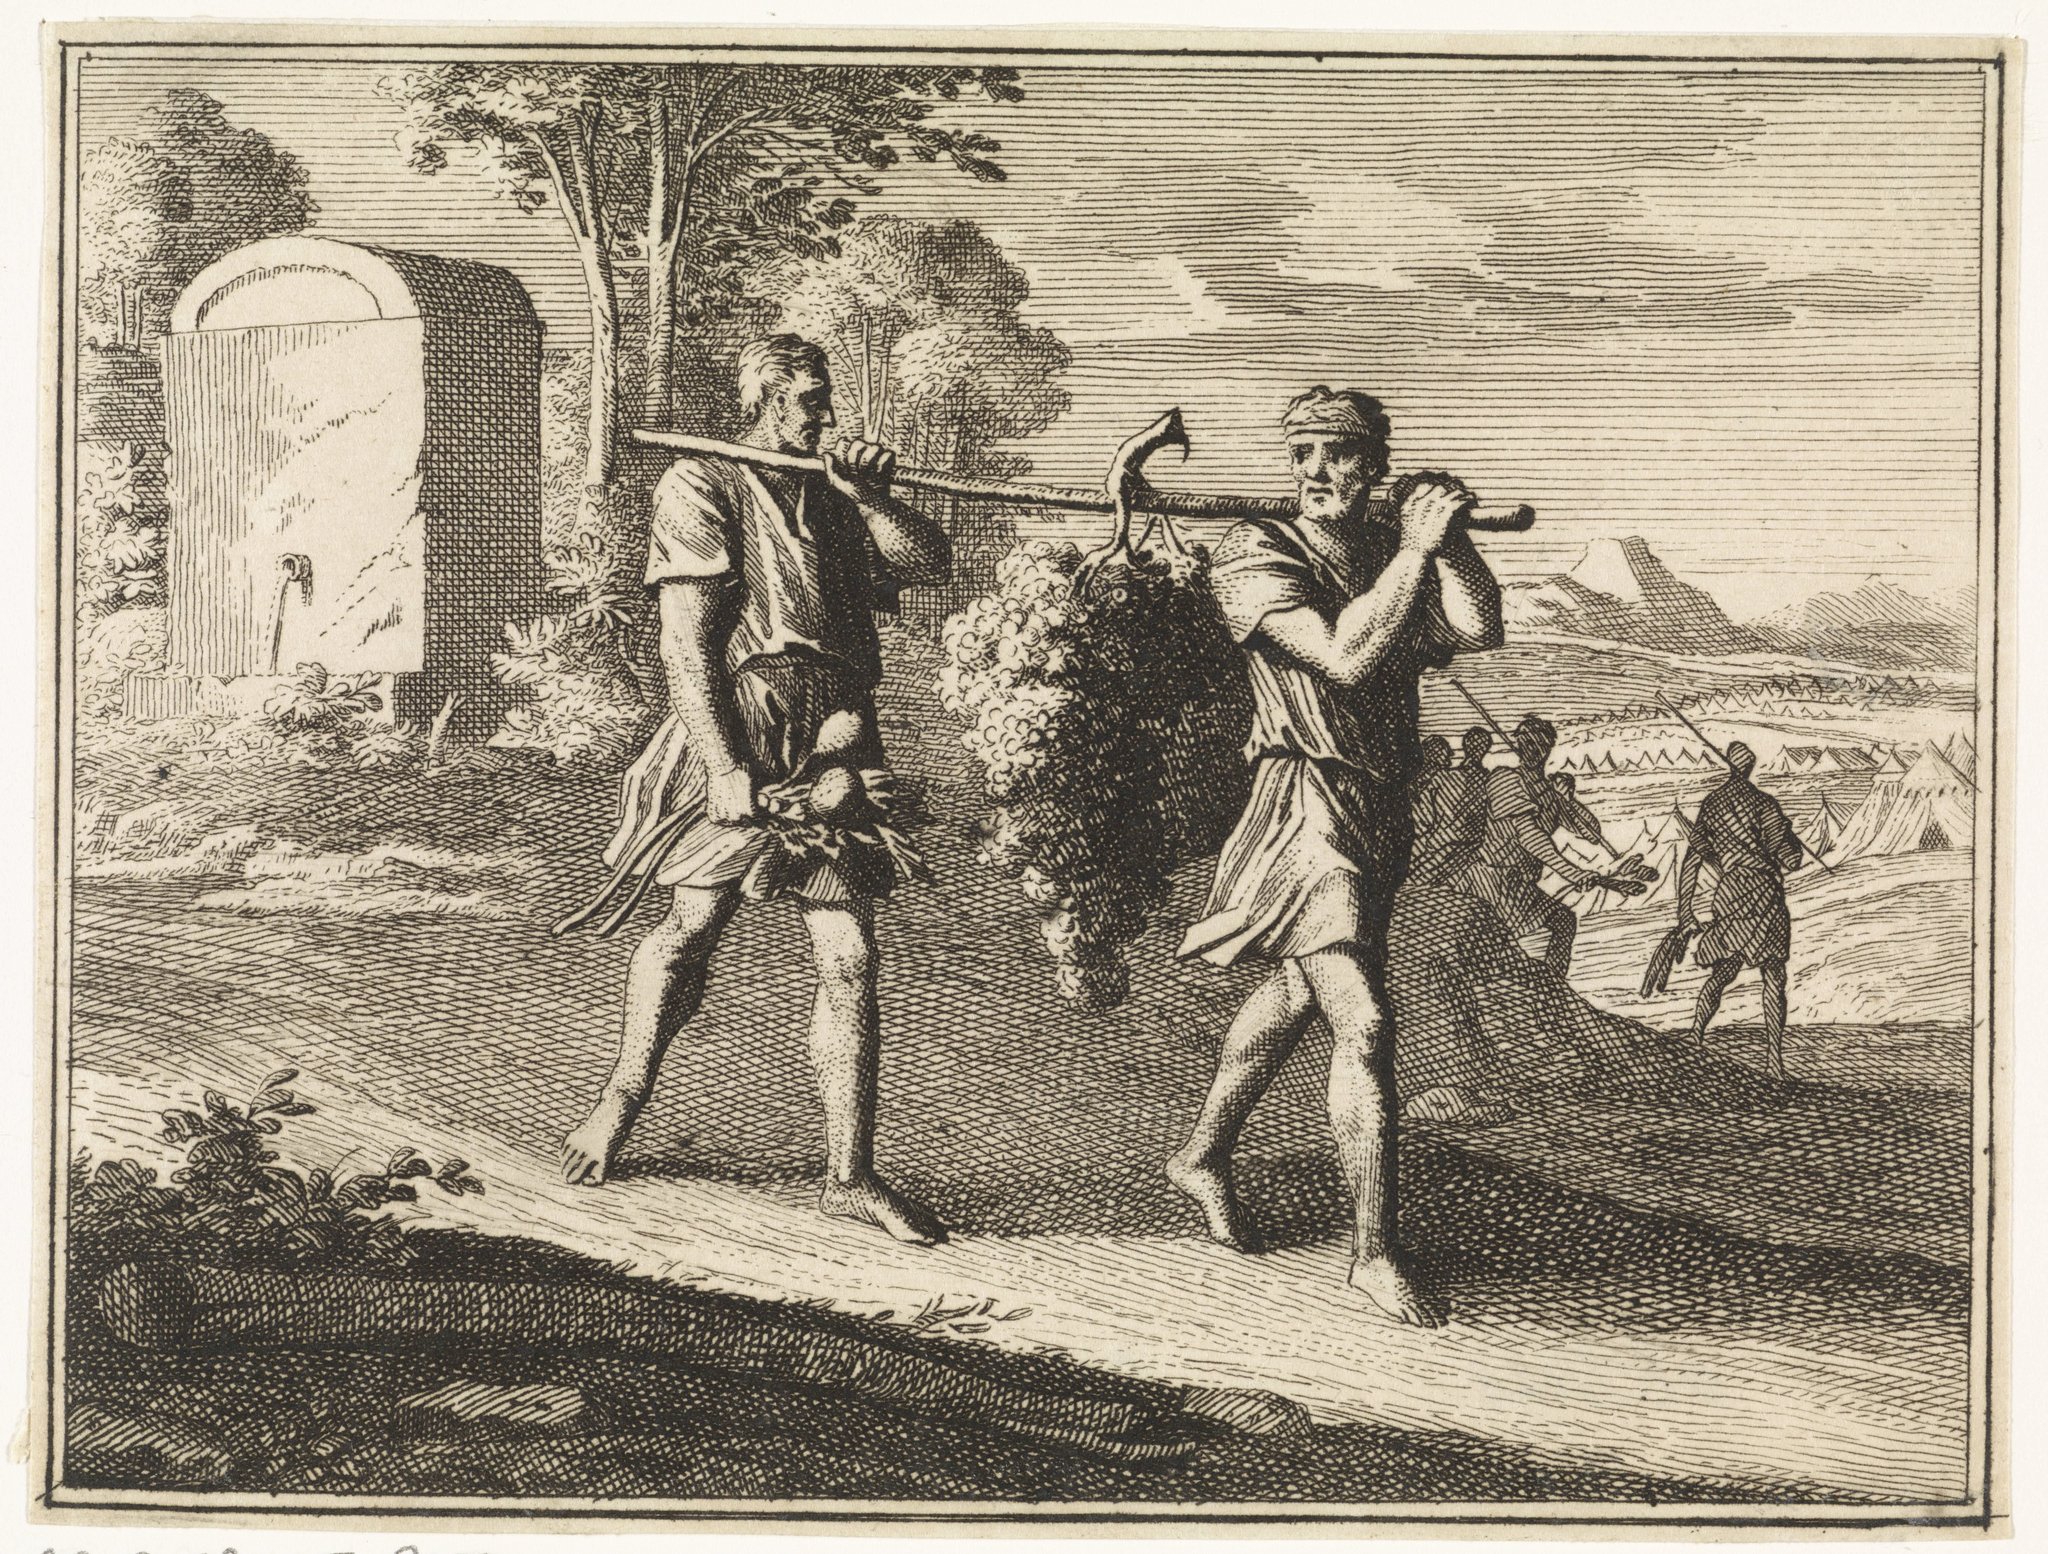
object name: print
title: Terugkeer van de verkenners uit Kanaän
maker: caspar luyken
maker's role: draughtsman, print maker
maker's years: 1672-1708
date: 1712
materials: paper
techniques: etching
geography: amsterdam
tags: the spies take away some of the fruits of canaan and return, usually carrying a large bunch of grapes on a pole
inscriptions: number: ‘71’, collector's mark: Lugt 2228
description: Illustratie uit: Luyken, Jan. De schriftuurlyke geschiedenissen en gelykenissen van het Oude en Nieuwe Verbond, 2 delen. Amsterdam: Wed. Pieter Arentsz II en Cornelis van der Sys, 1712, dl. I.